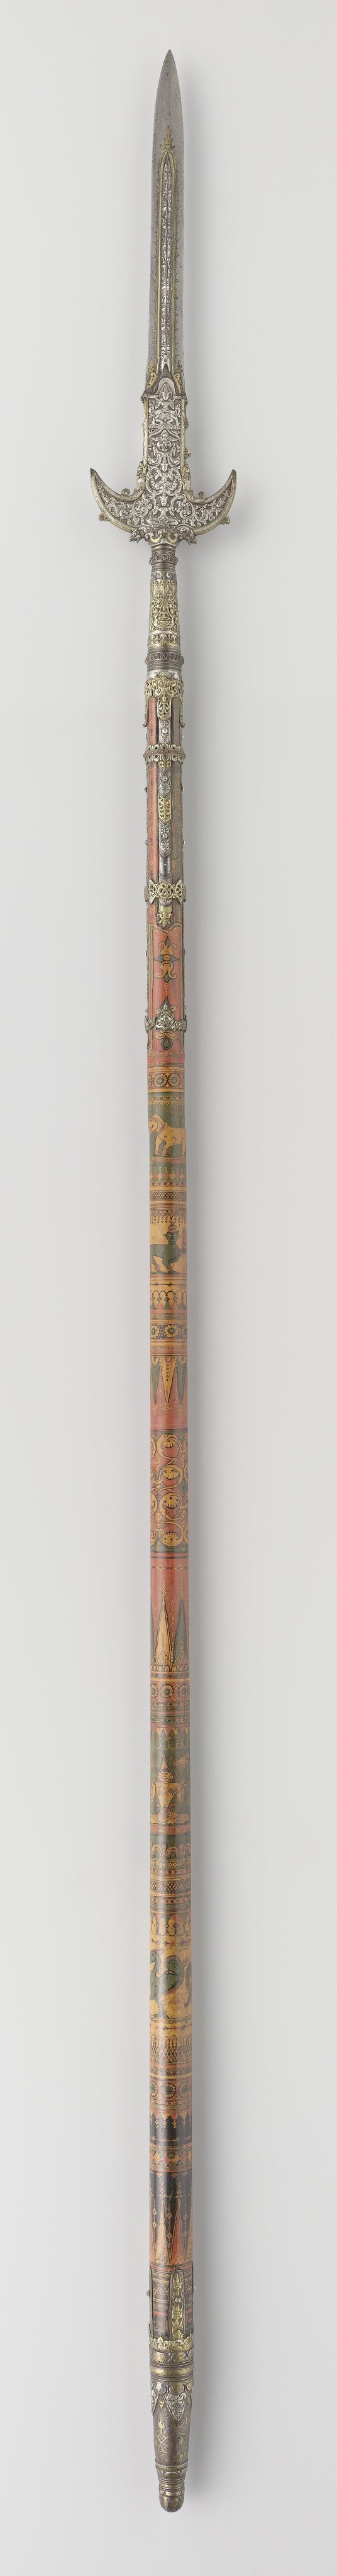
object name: partisan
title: Partizaan van het wapenrek door Indische groten geschonken aan Gouverneur-Generaal J.C. baron Baud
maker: Anonymous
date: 1700-1800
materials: copper, iron, paint, gemstone, silver, wood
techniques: casting, cutting, forging, inlay, painted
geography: india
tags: the hague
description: Partisan India or Ceylon (Sri Lanka), 18th century. The shape of this ceremonial weapon is European, but the decoration is Buddhist.